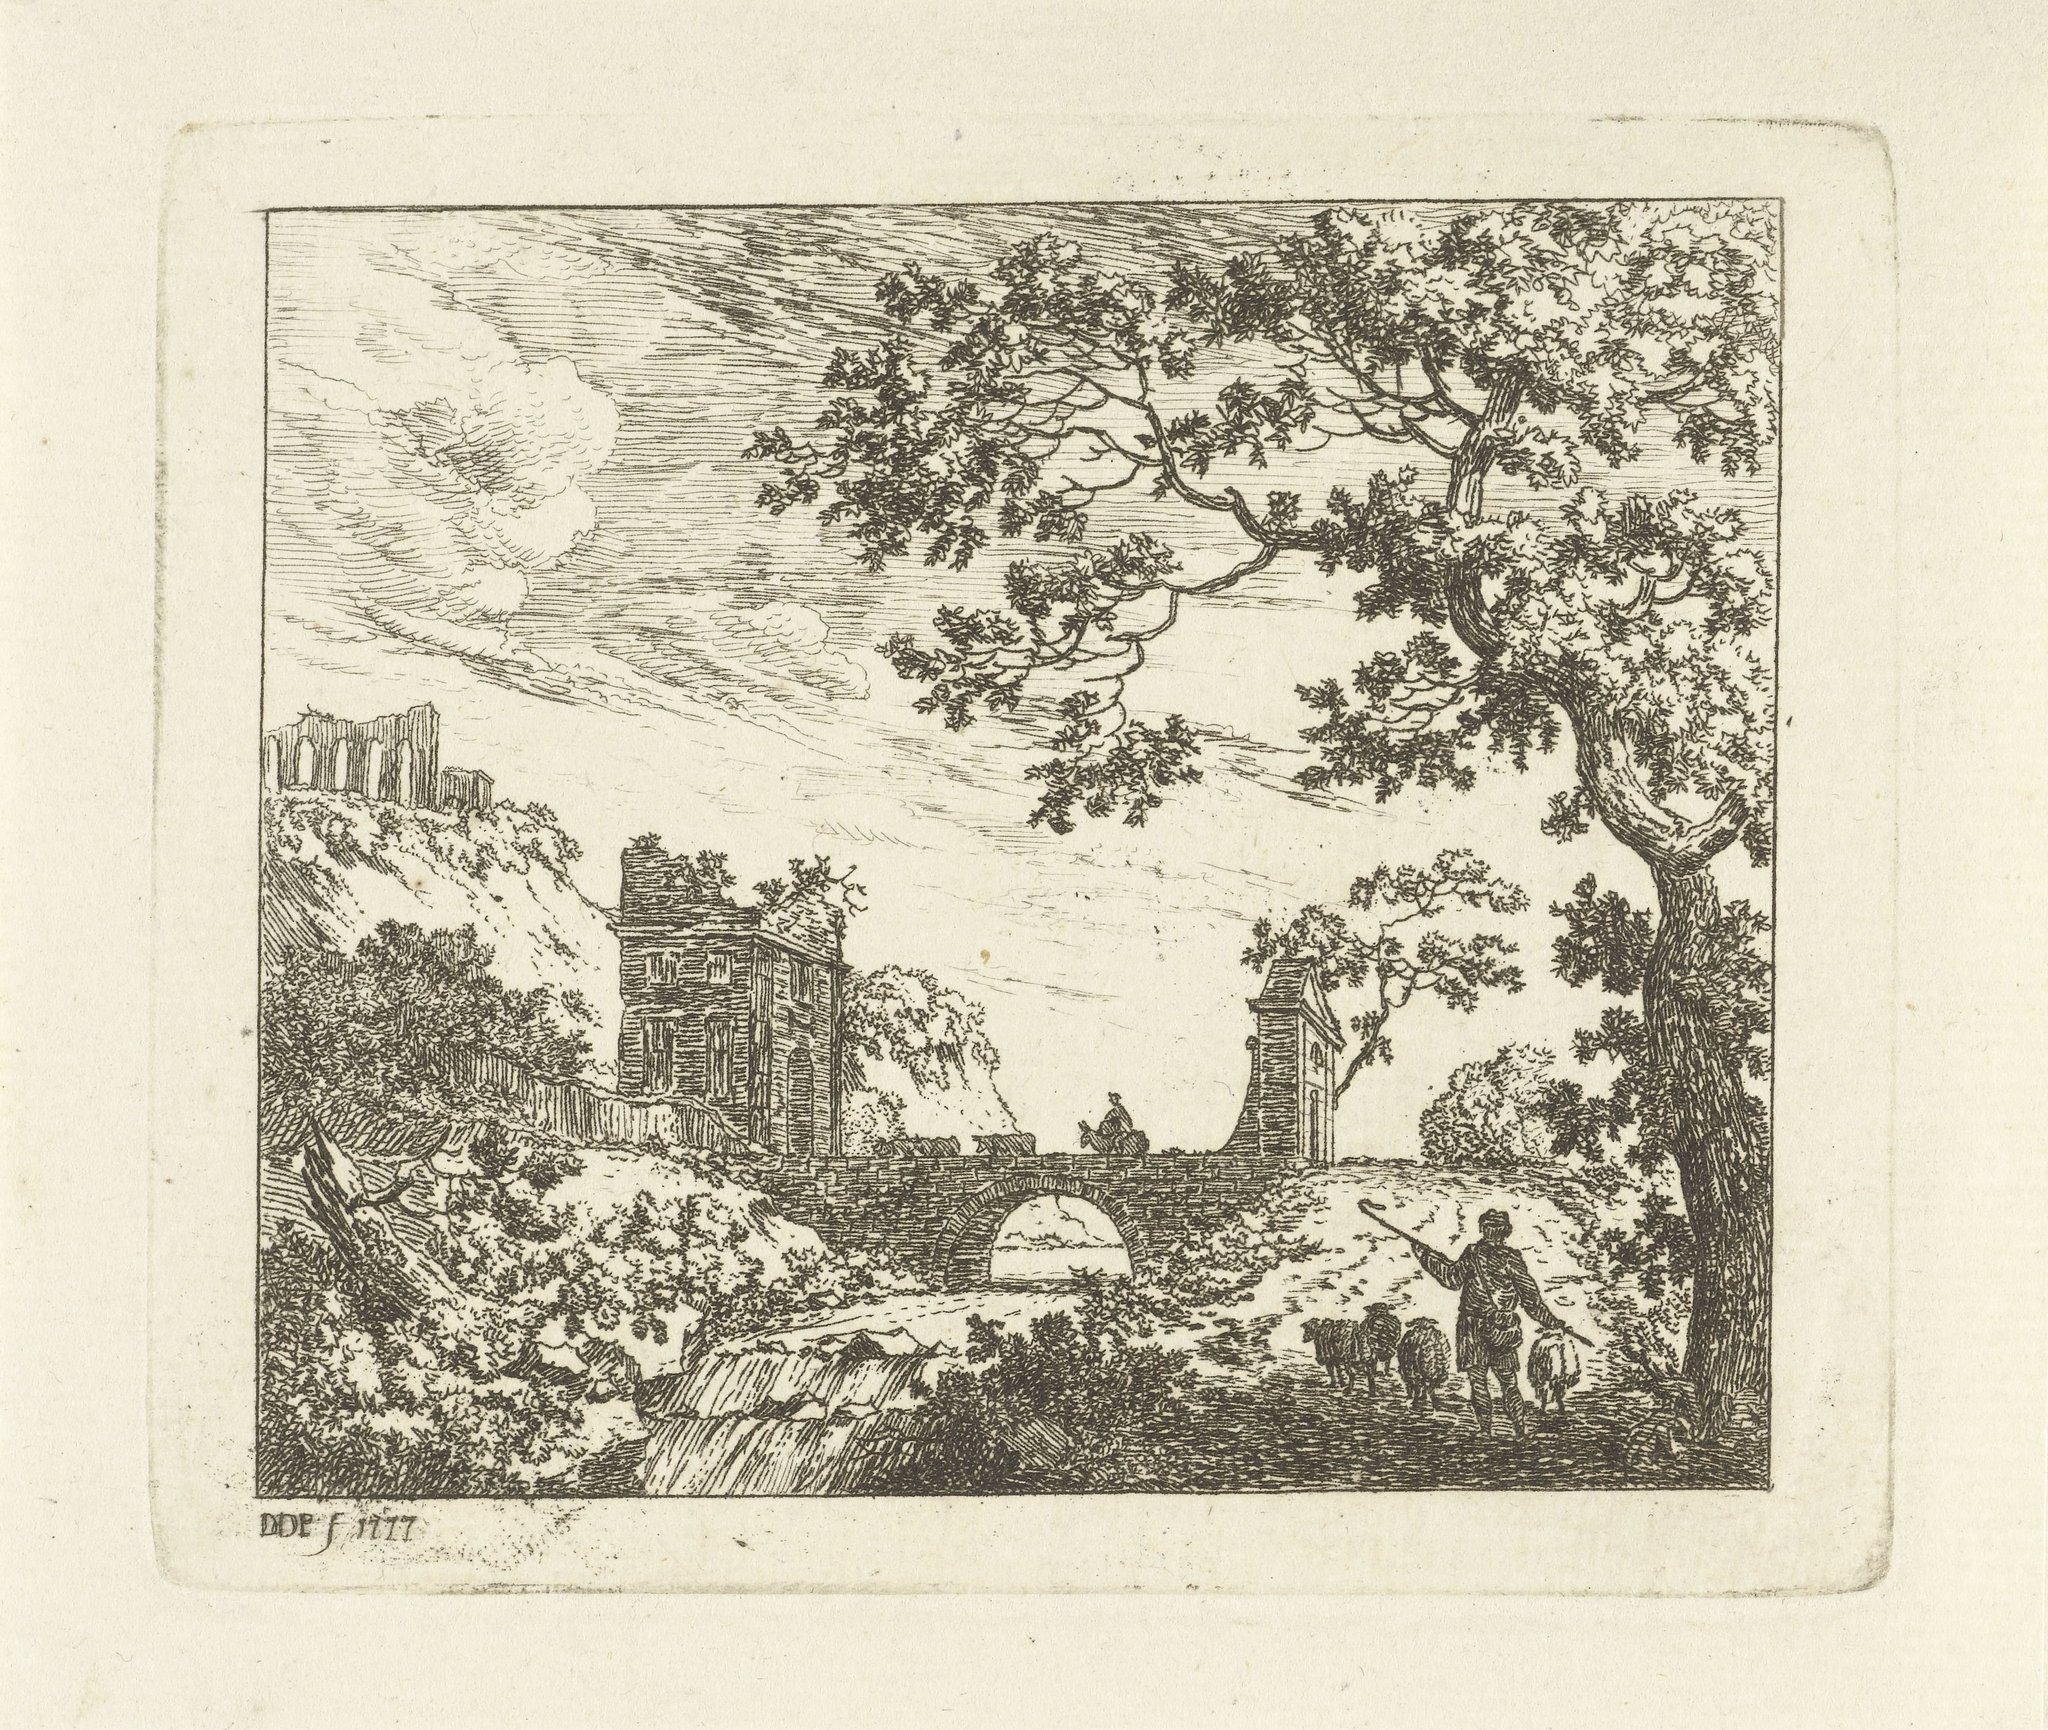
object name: print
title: Gezicht op een brug over een rivier met een waterval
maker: daniël dupré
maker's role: draughtsman, print maker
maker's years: 1751-1817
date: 1777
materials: paper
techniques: etching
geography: netherlands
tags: waterfall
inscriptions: collector's mark: Lugt 240